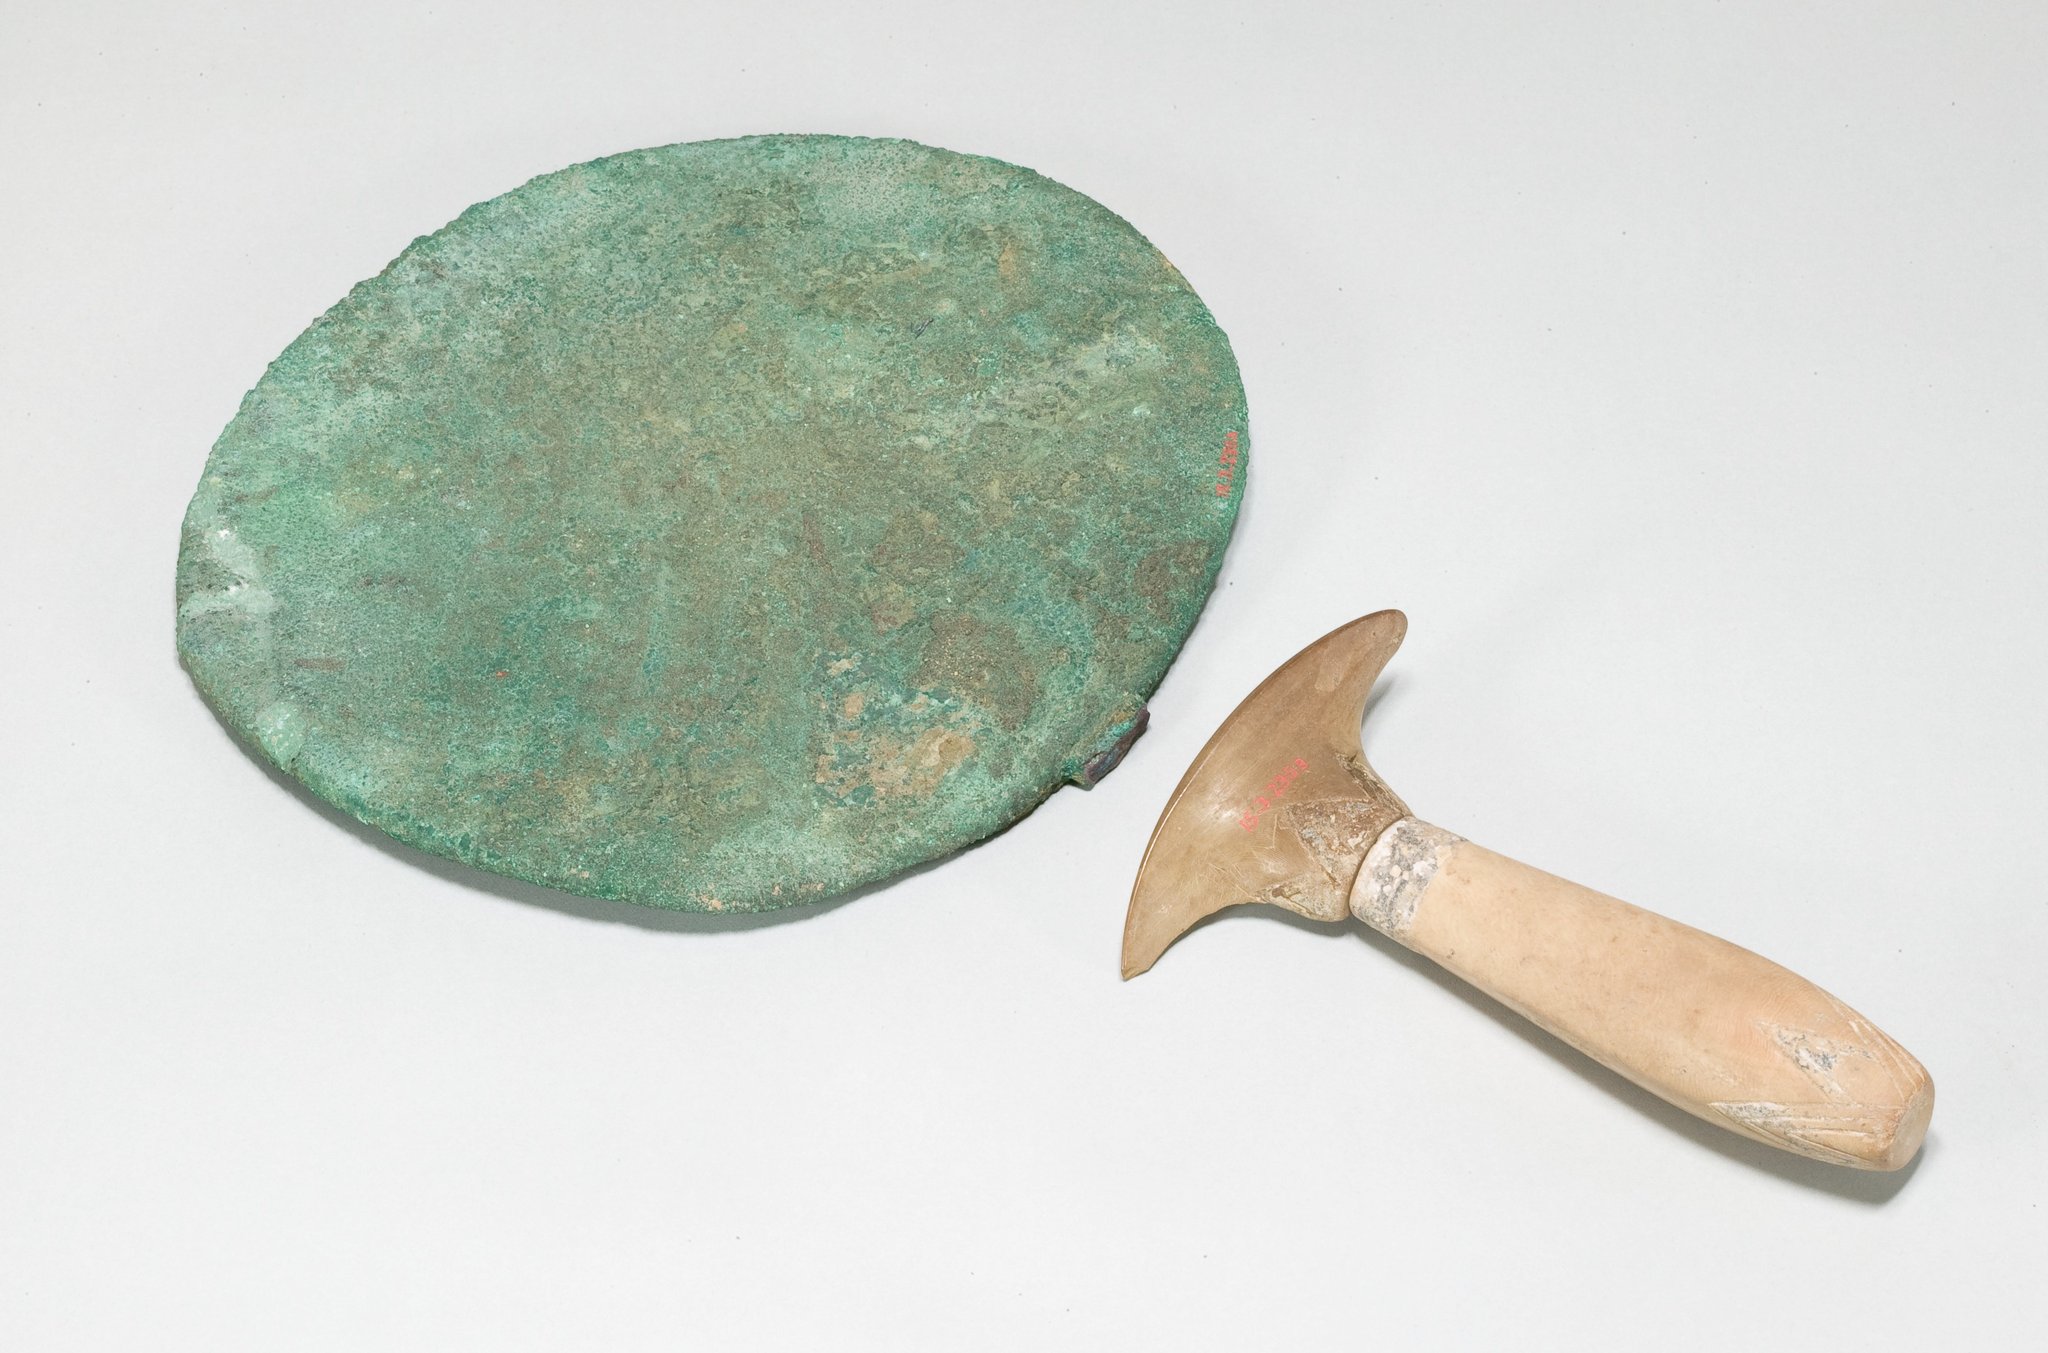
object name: mirror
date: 1900-1850 BCE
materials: bronze, copper alloy, ivory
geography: egypt